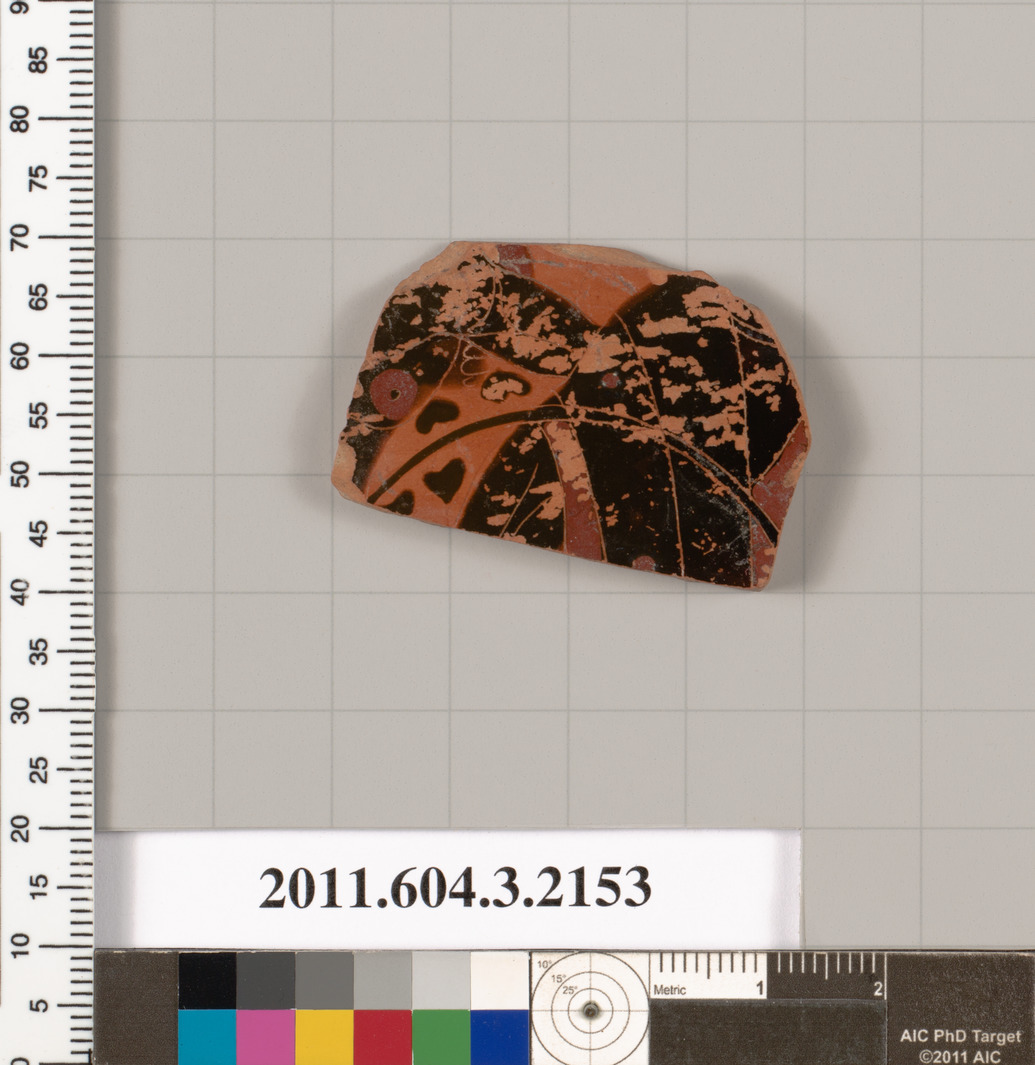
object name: kylix fragment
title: Terracotta fragment of a kylix (drinking cup)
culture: greek, attic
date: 525-501 BCE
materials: terracotta